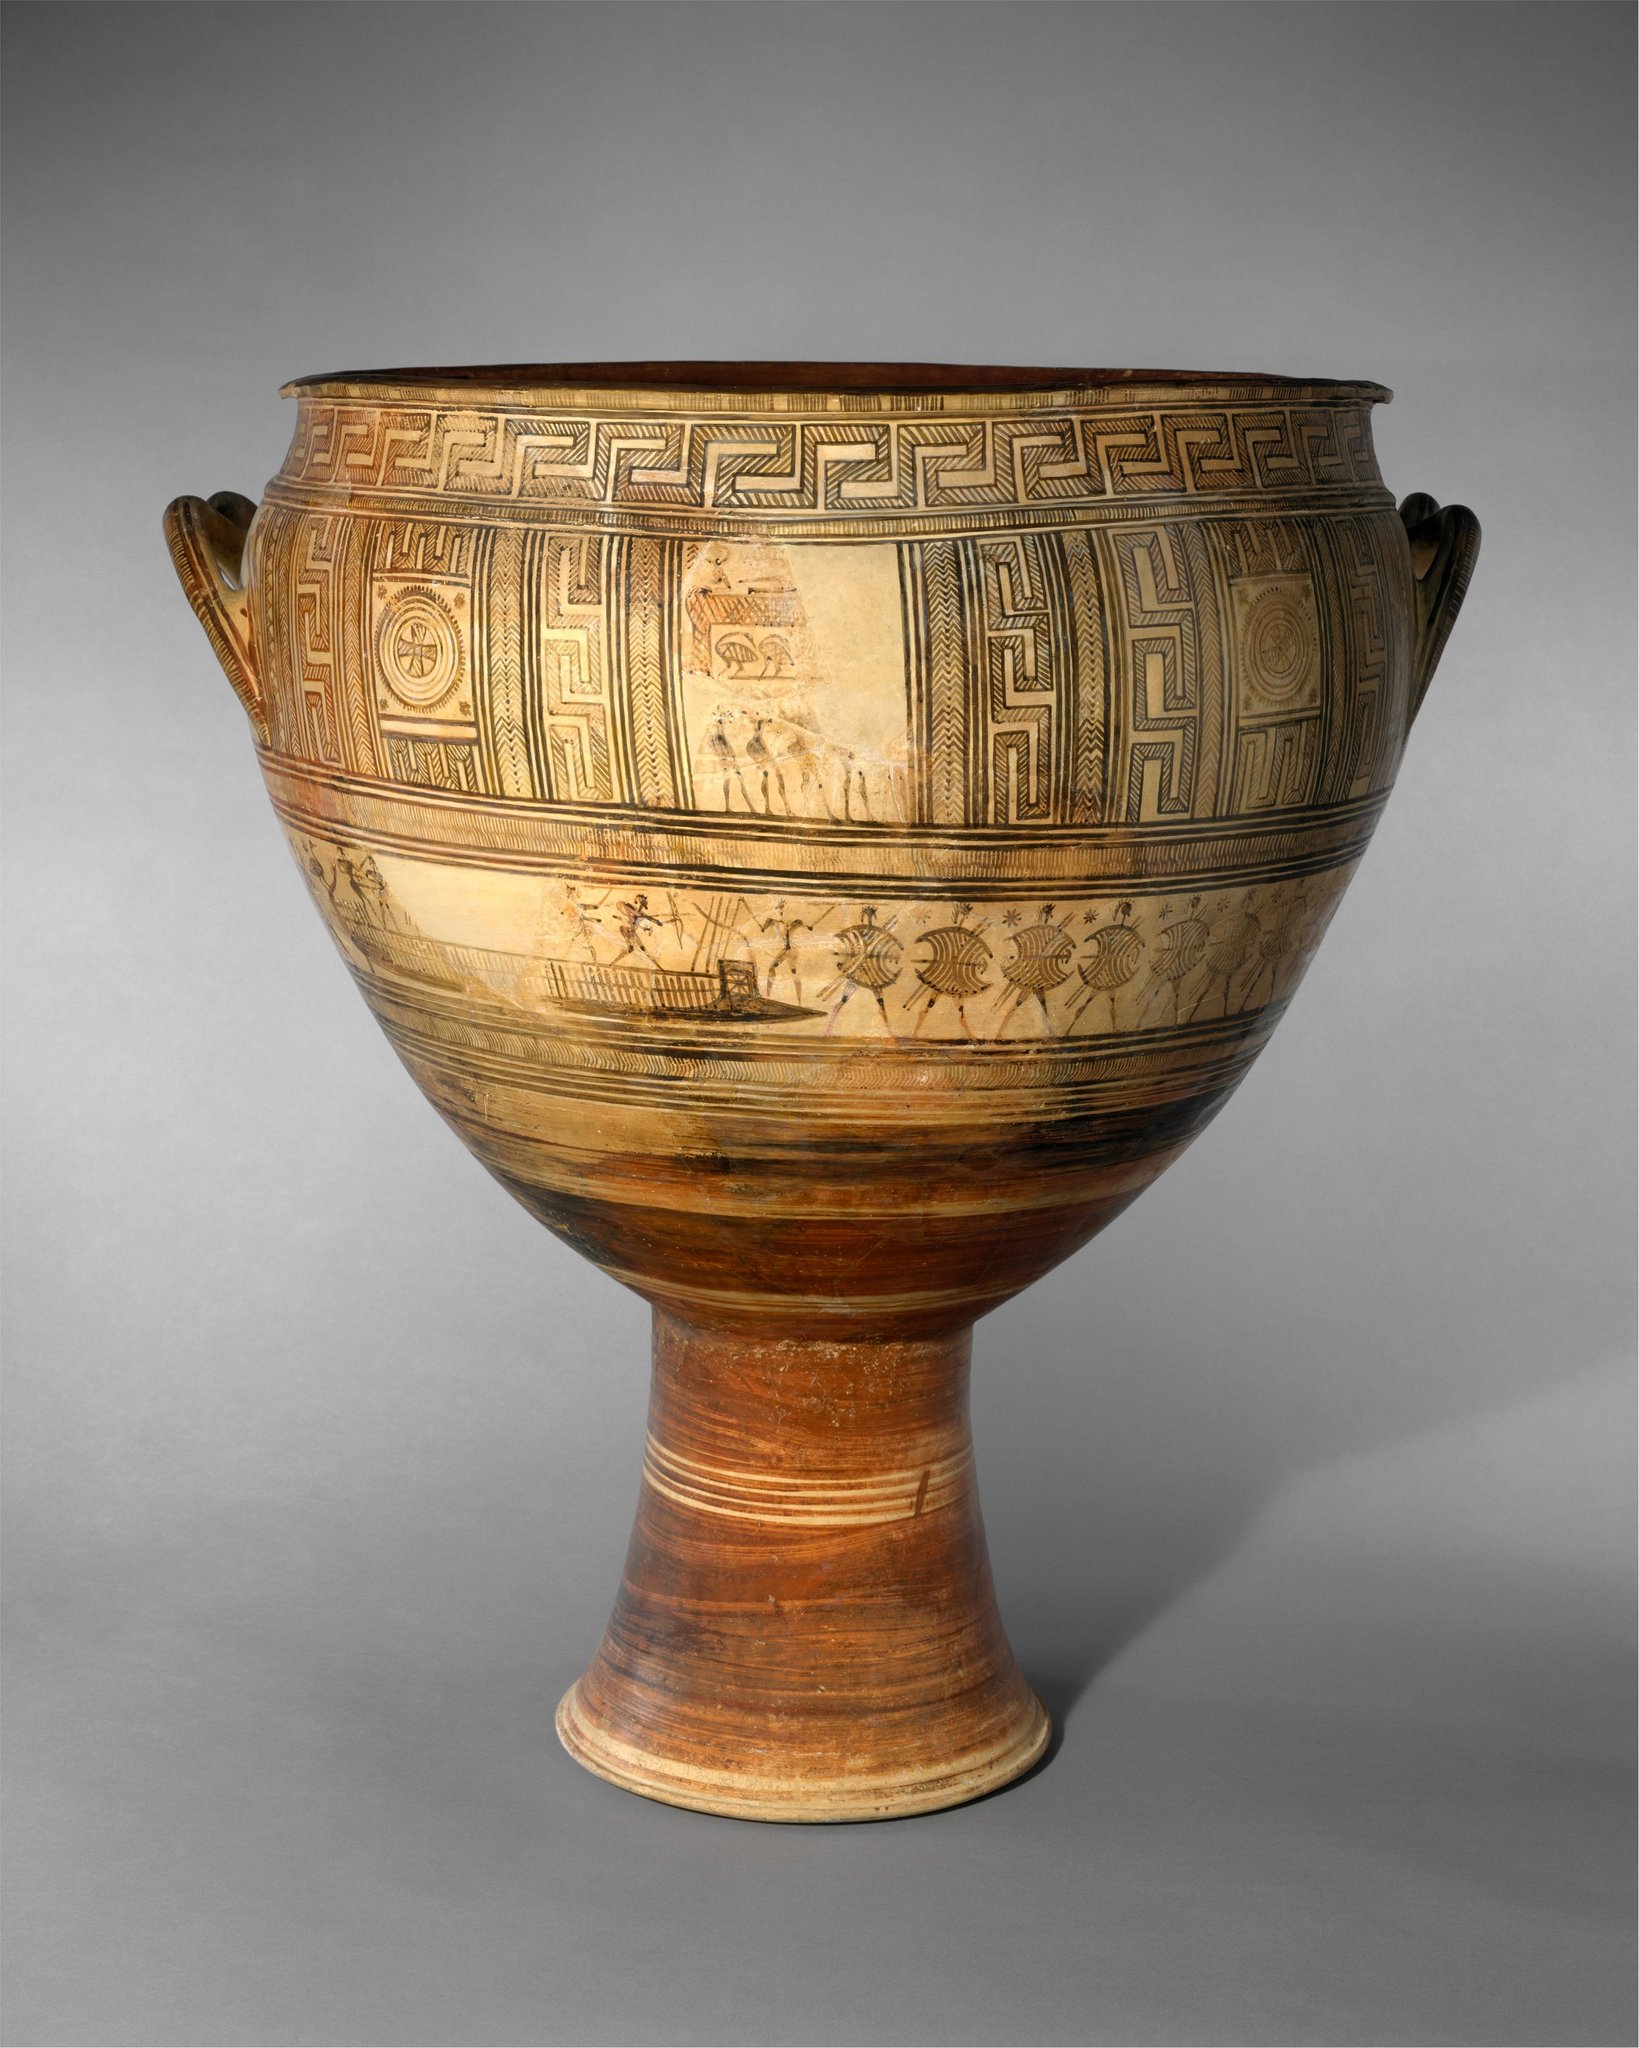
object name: krater, dipylon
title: Terracotta krater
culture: greek, attic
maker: workshop of new york mma 34.11.2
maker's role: artist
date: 775 BCE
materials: terracotta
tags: human figures,ships